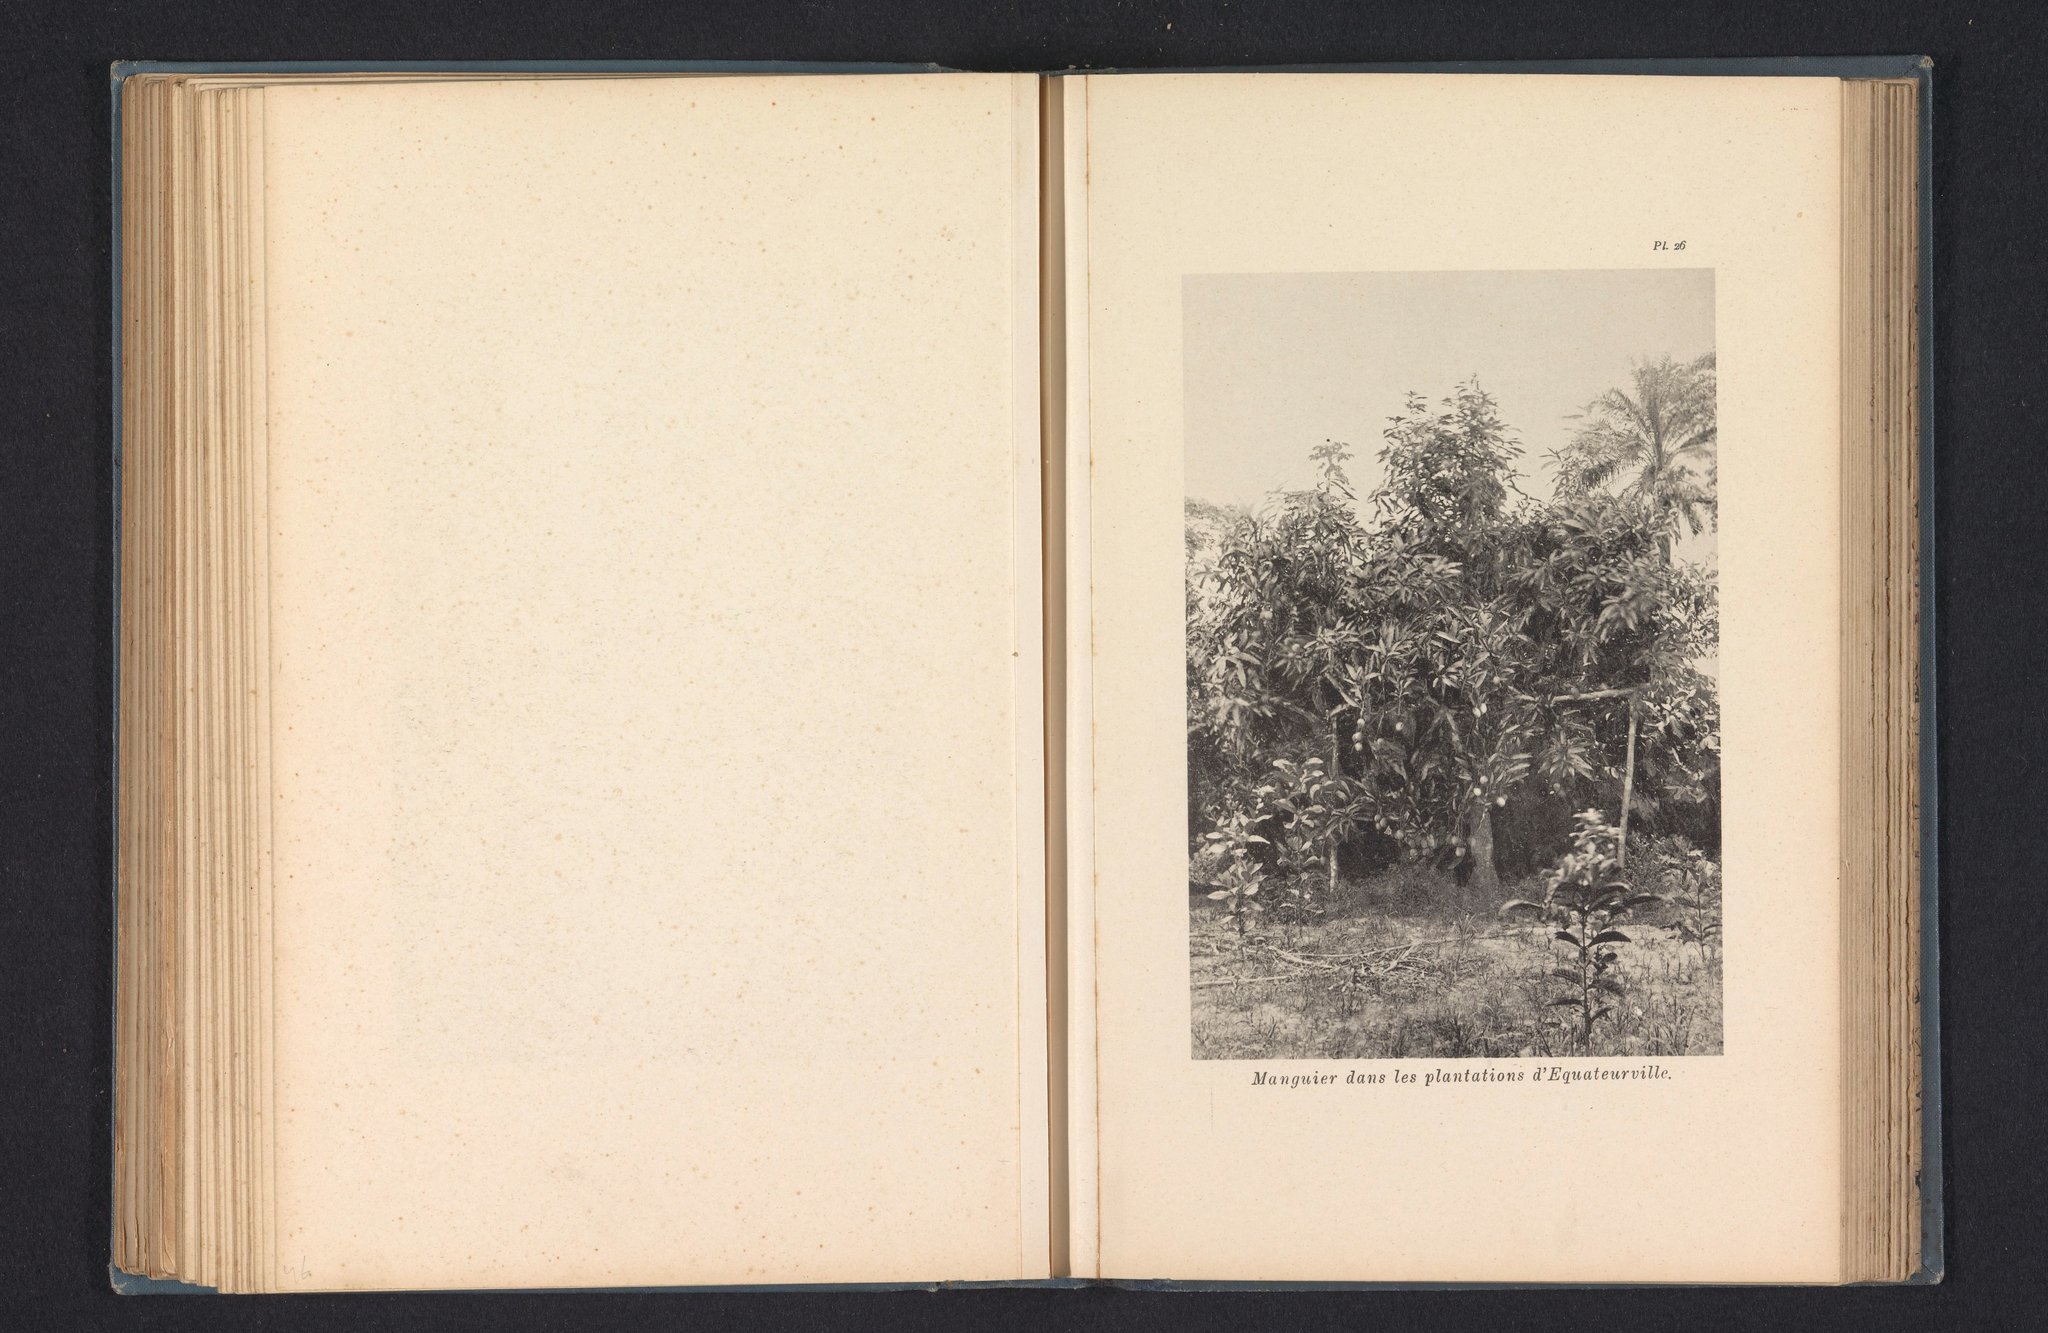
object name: page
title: Mangoboom op een plantage te Equateurville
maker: franz thonner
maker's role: botanicus, ontdekkingsreiziger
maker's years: 1863-1928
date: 1896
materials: paper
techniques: photograph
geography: dresden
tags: plantation, fruit-tree culture; fruit harvest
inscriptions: number: ‘Pl. 26.’